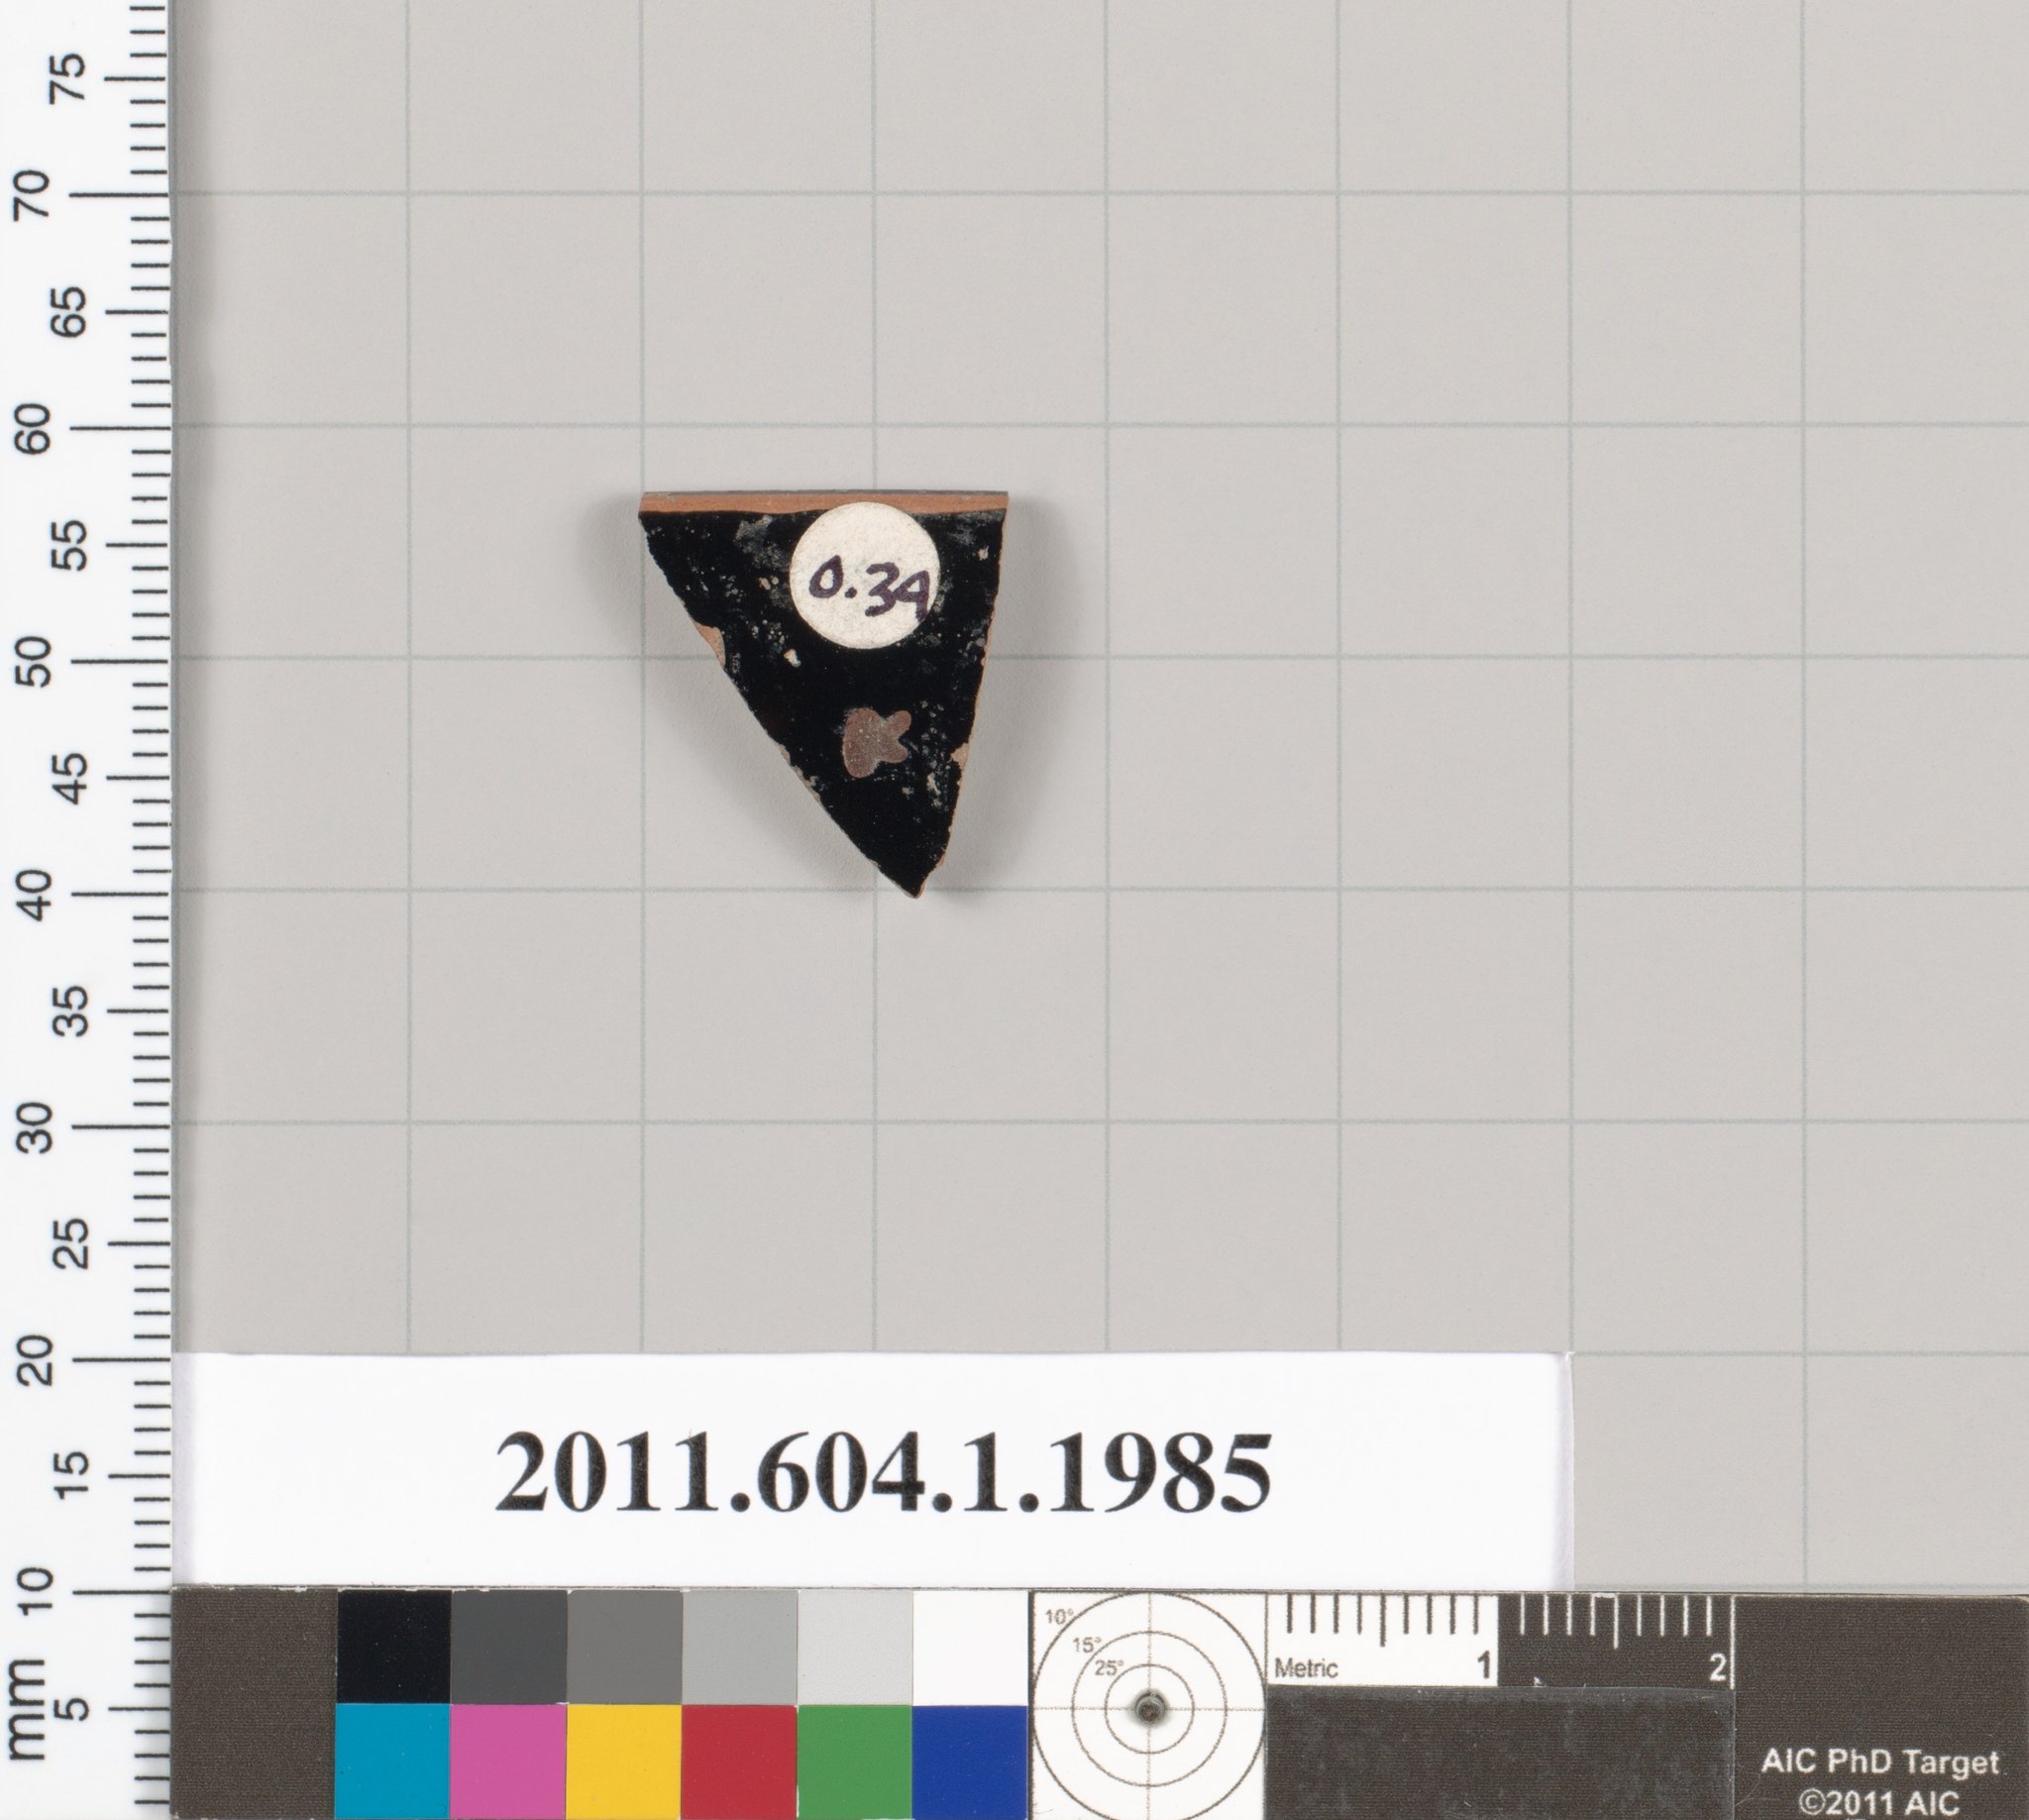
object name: kylix fragment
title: Terracotta rim fragment of a kylix (drinking cup)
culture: greek, attic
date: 500-401 BCE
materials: terracotta